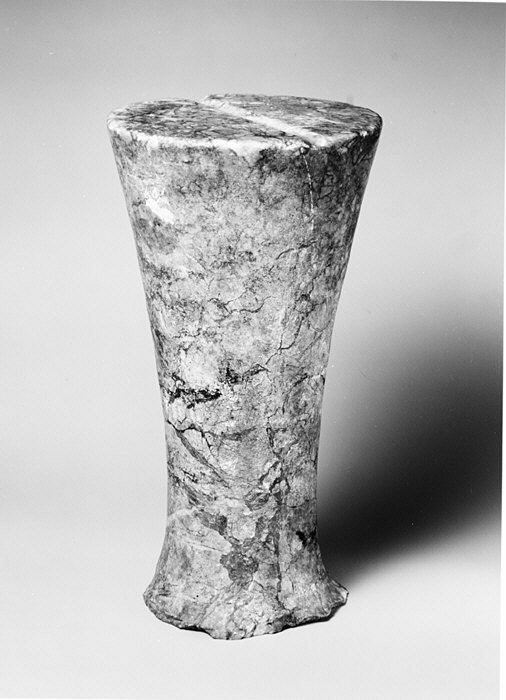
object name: incense stand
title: Incense stand (?)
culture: bactria-margiana archaeological complex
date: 2333-1668 BCE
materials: marble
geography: bactria-margiana